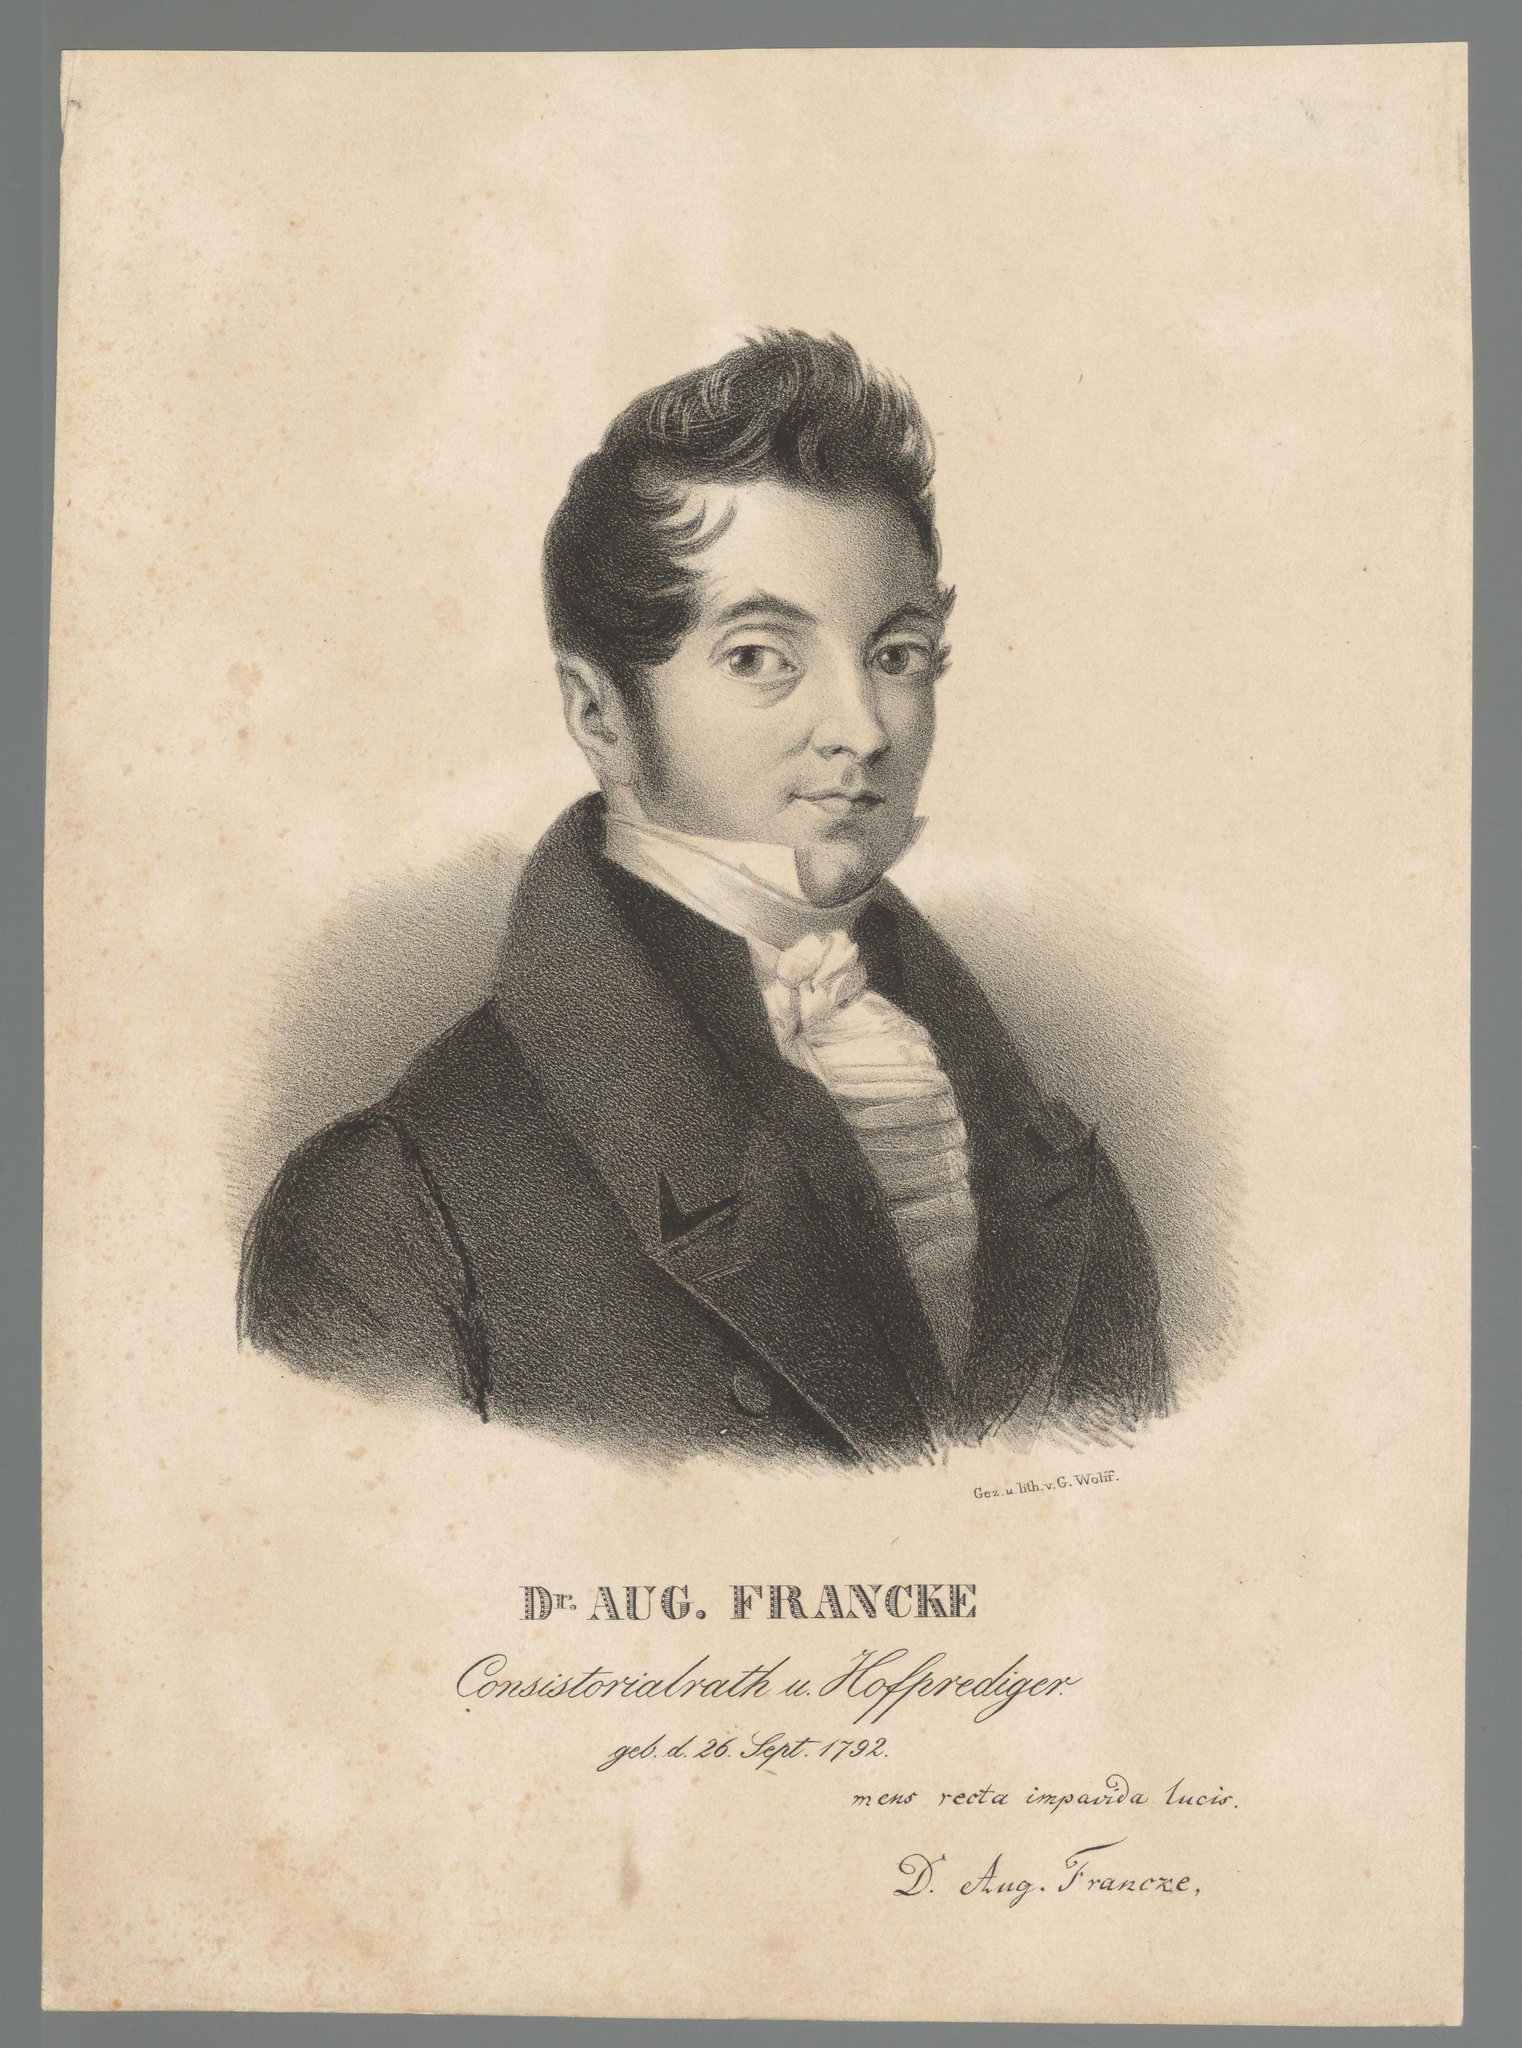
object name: print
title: Dr. Aug. Francke, Consistorialrath u. Hofprediger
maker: gustav wolff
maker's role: print maker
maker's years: 1800-1846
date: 1810-1846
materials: paper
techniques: lithograph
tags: adult man, historical persons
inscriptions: collector's mark: Lugt 2228